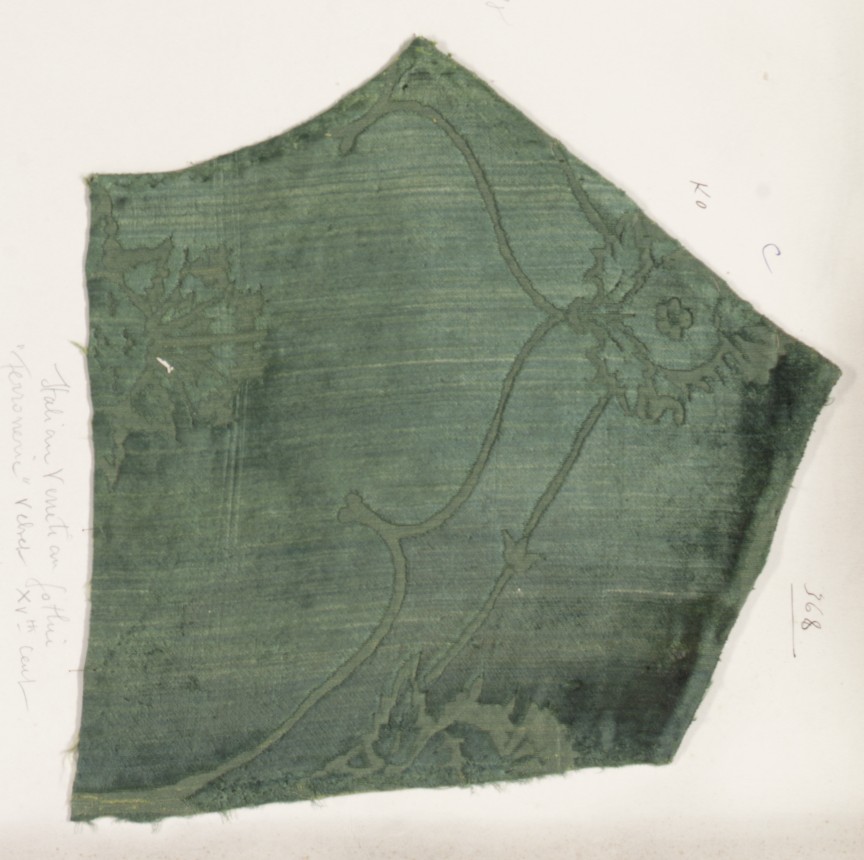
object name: fragment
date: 1401-1500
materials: silk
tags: flowers